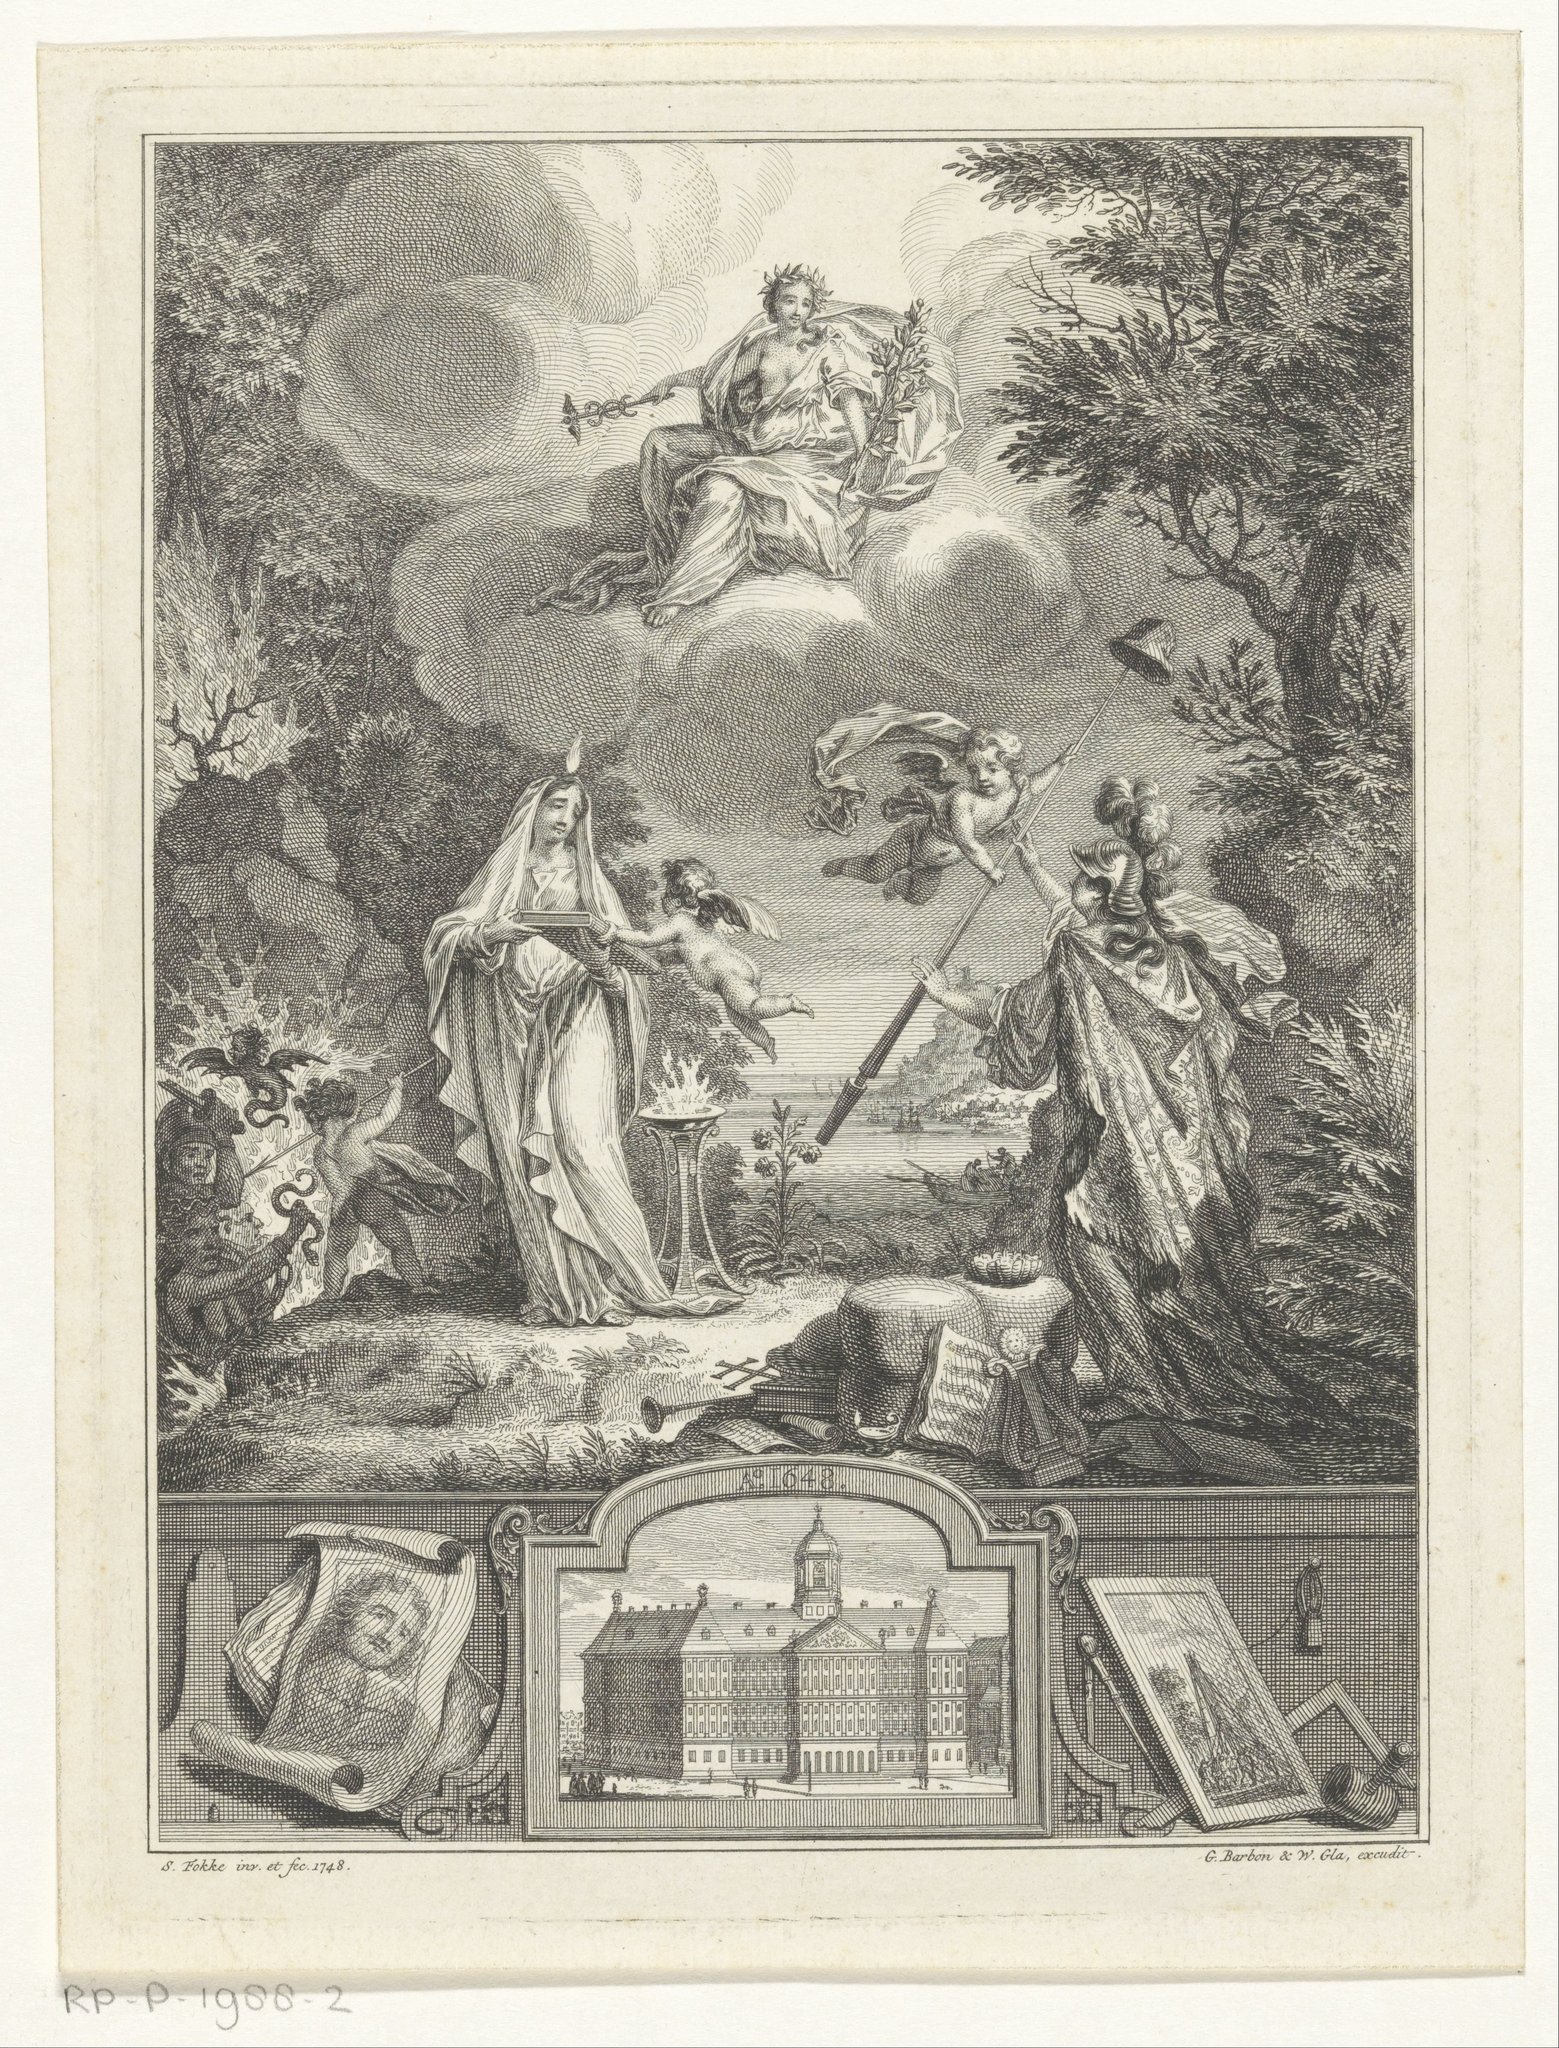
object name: book illustration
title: Allegorie op het 100-jarig jubileum van Nederlands Vrijheid, 1648-1748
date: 1748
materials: paper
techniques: engraving, etching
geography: amsterdam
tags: haarlem, print maker, draughtsman, jacob van campen, freedom, liberty; 'libertà' (ripa)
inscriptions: collector's mark: Lugt 2760, collector's mark: Lugt 2228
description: De gelauwerde personificatie van de Vrede troont in de lucht met een olijftak en een caduceus. Onder haar ontvangt Minerva een lans met vrijheidshoed van een putto. Een tweede putto biedt de Waakzaamheid in het midden een boek aan. Geheel links jaagt een derde putto duivelse figuren met een speer een vlammenzee in. Aan de onderzijde het in 1648 voltooide Stadhuis op de Dam te Amsterdam met een portret van Jacob van Campen en een voorstelling van heiwerkzaamheden bij de bouw.